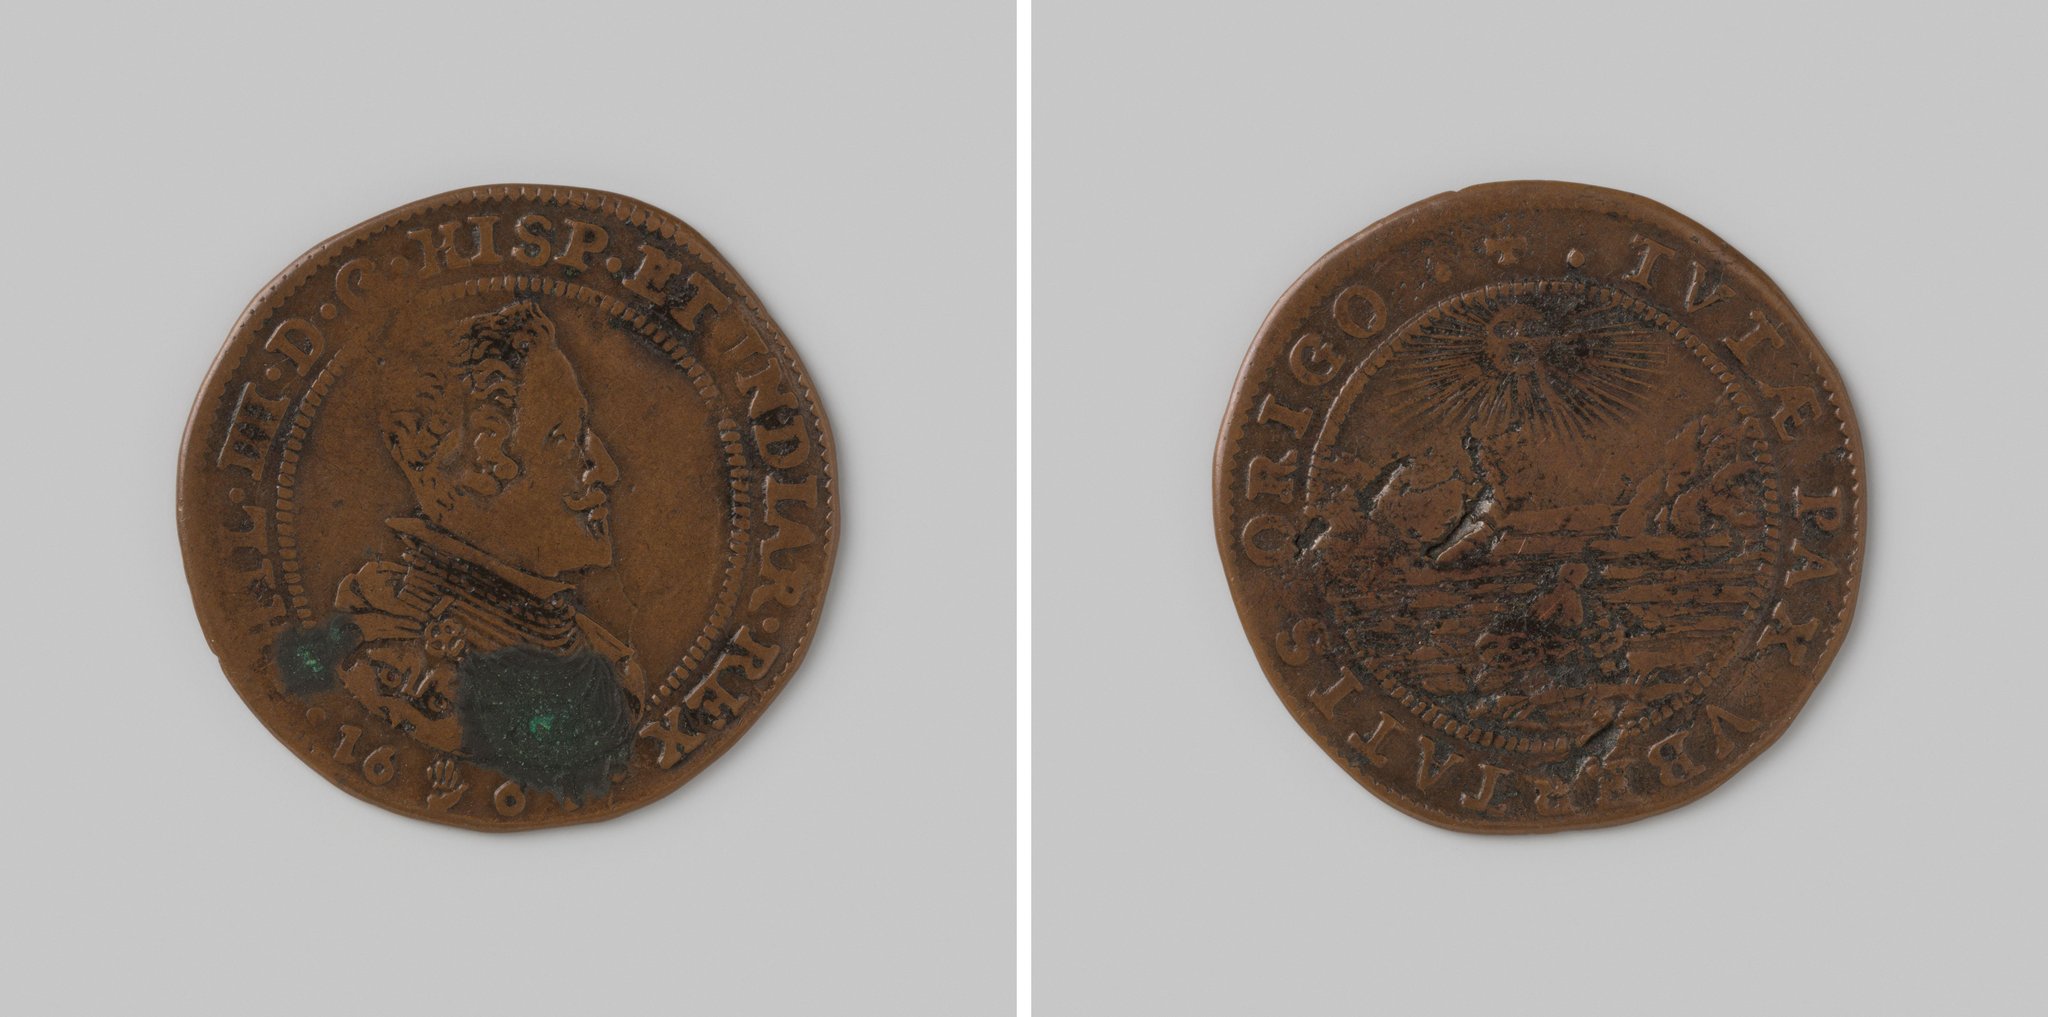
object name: jeton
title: Rekenpenning uit Antwerpen op de geboorte van de Spaanse prins 1661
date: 1661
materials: copper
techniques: striking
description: Koperen penning, op de voorzijde het borstbeeld van Philips IV naar rechts met omschrift, op de keerzijde een ijsvogel op een nest drijvend op een kalme zonbeschenen zee, met omschrift.